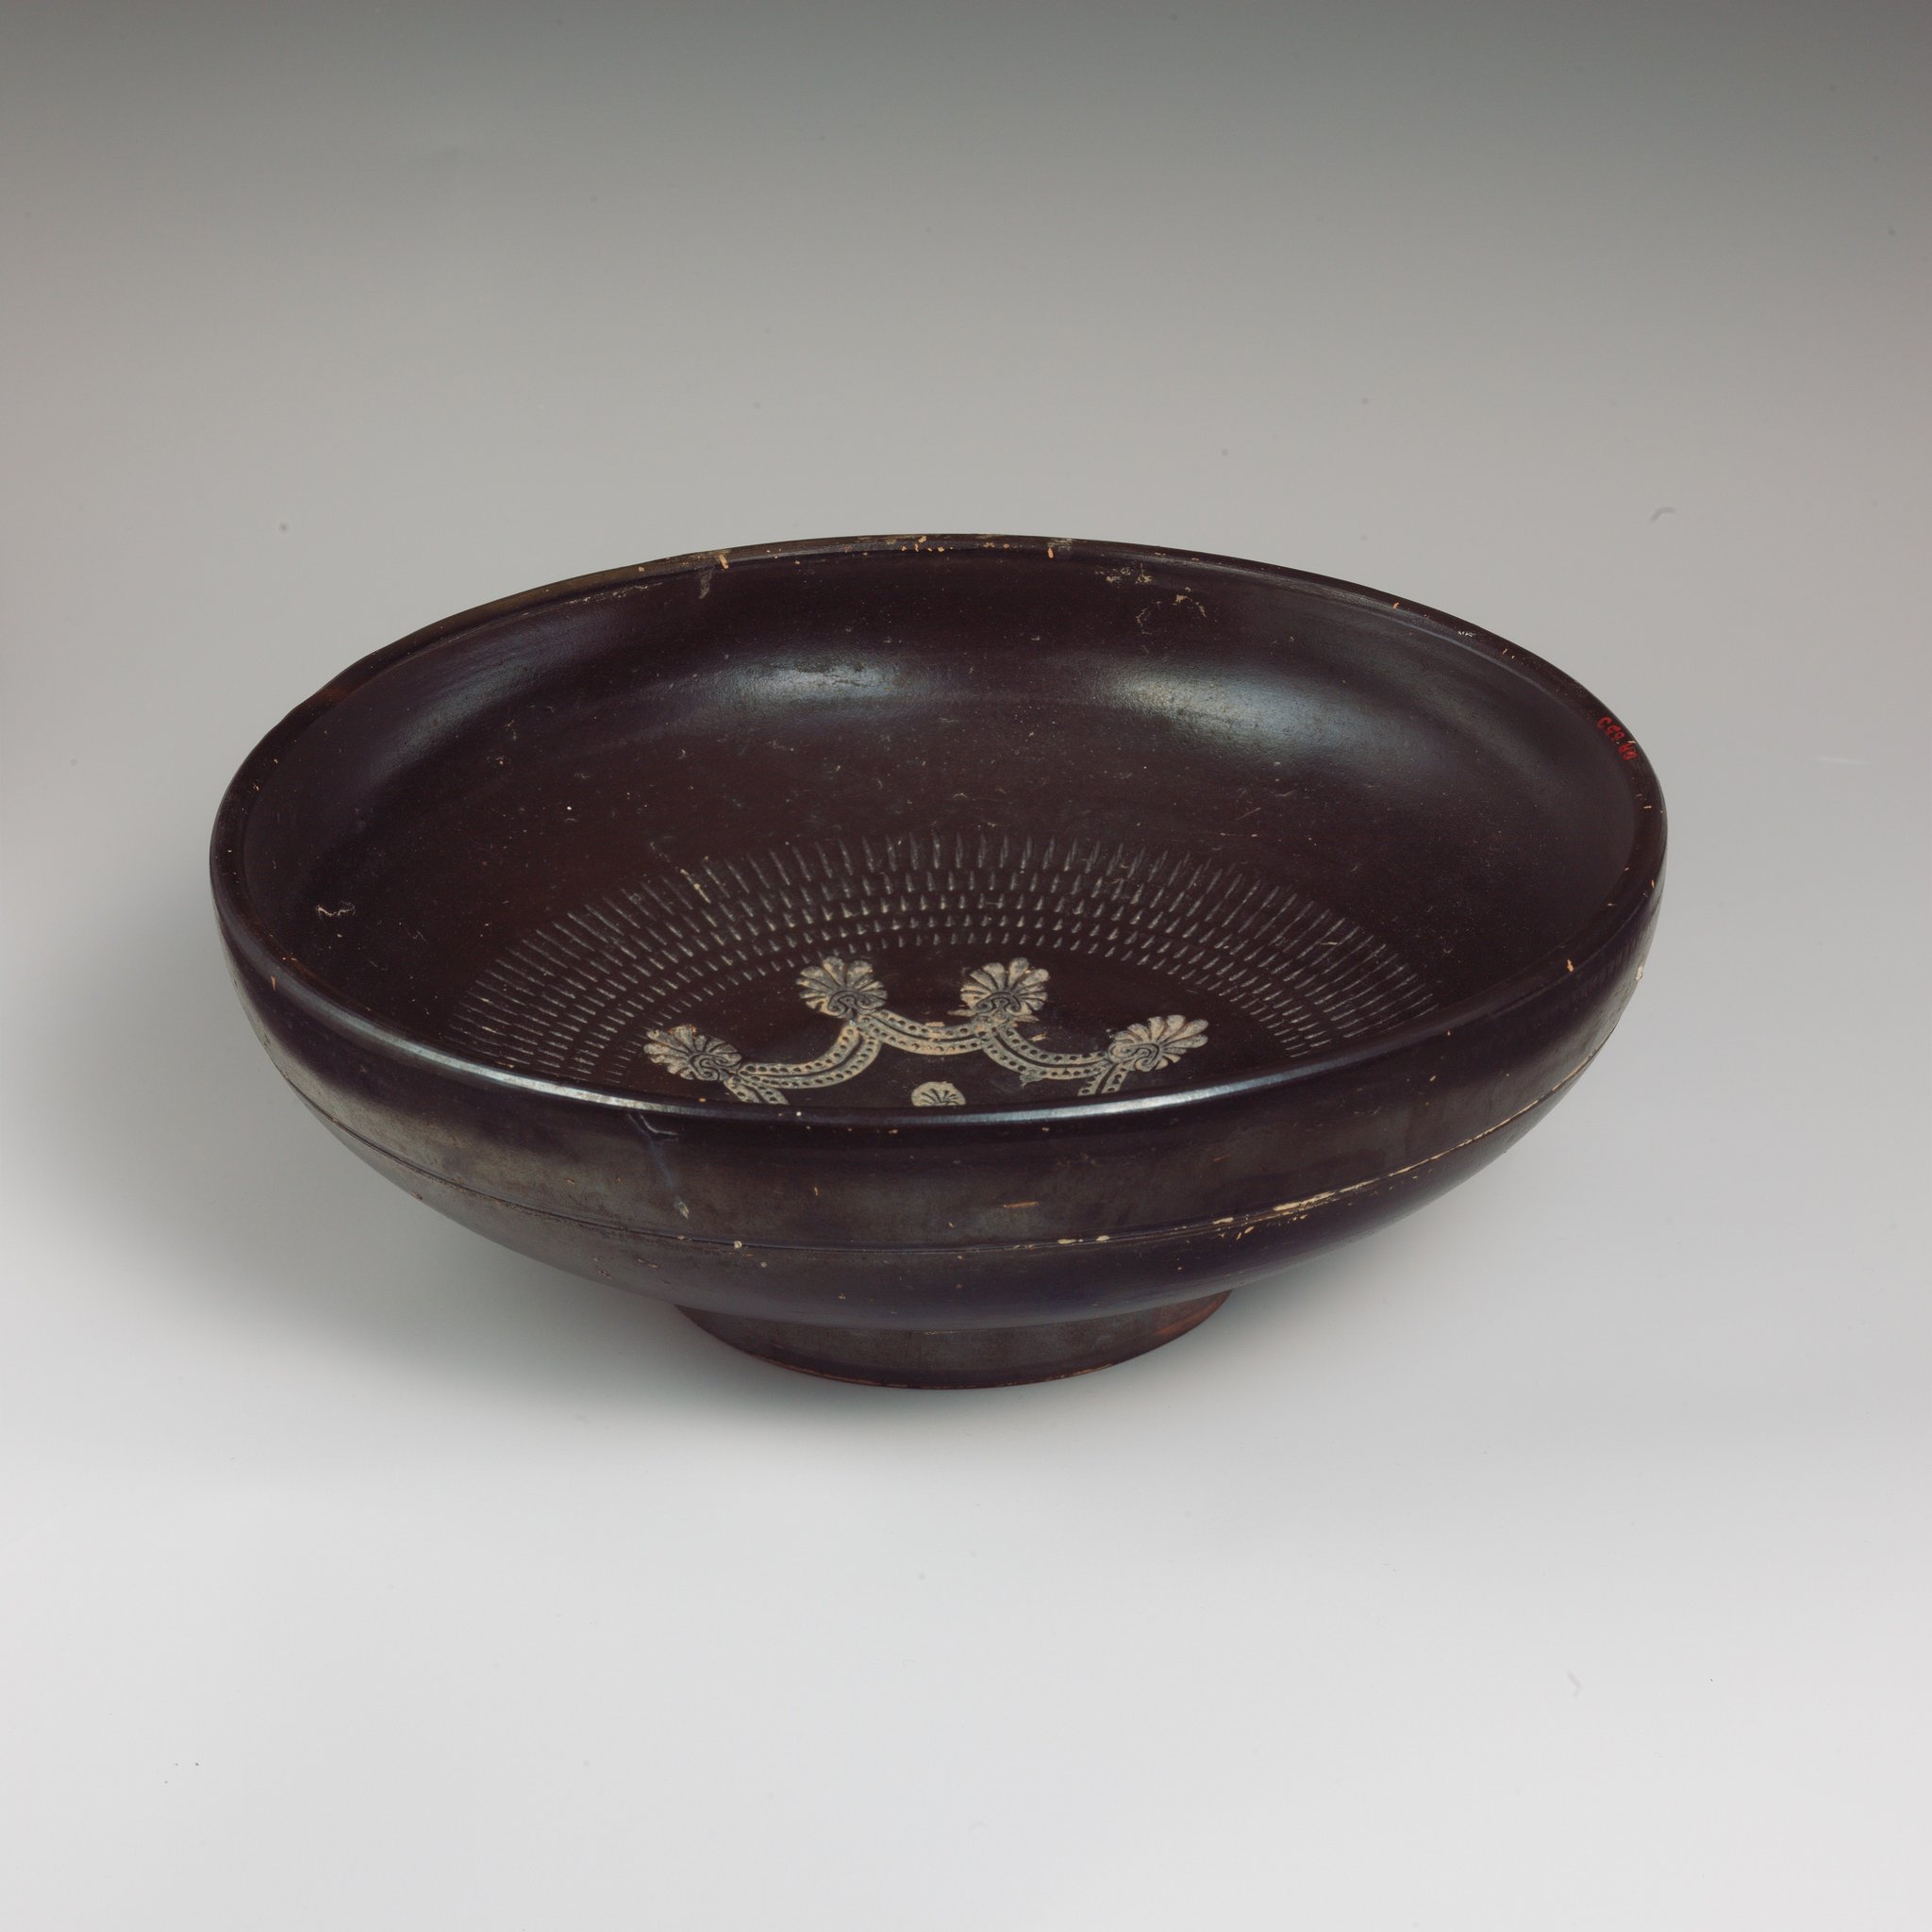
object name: bowl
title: Terracotta bowl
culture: greek or south italian or campanian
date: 400-301 BCE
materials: terracotta